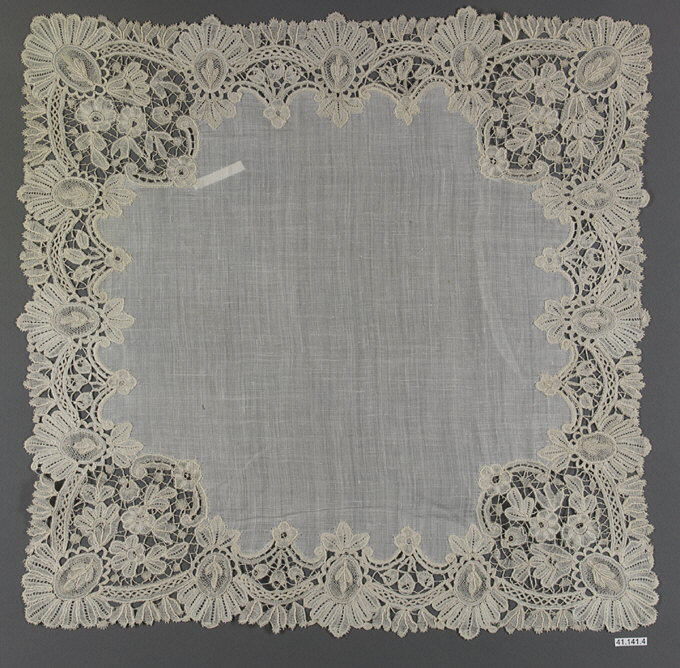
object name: handkerchief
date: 1875-1880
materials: lace, linen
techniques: lace